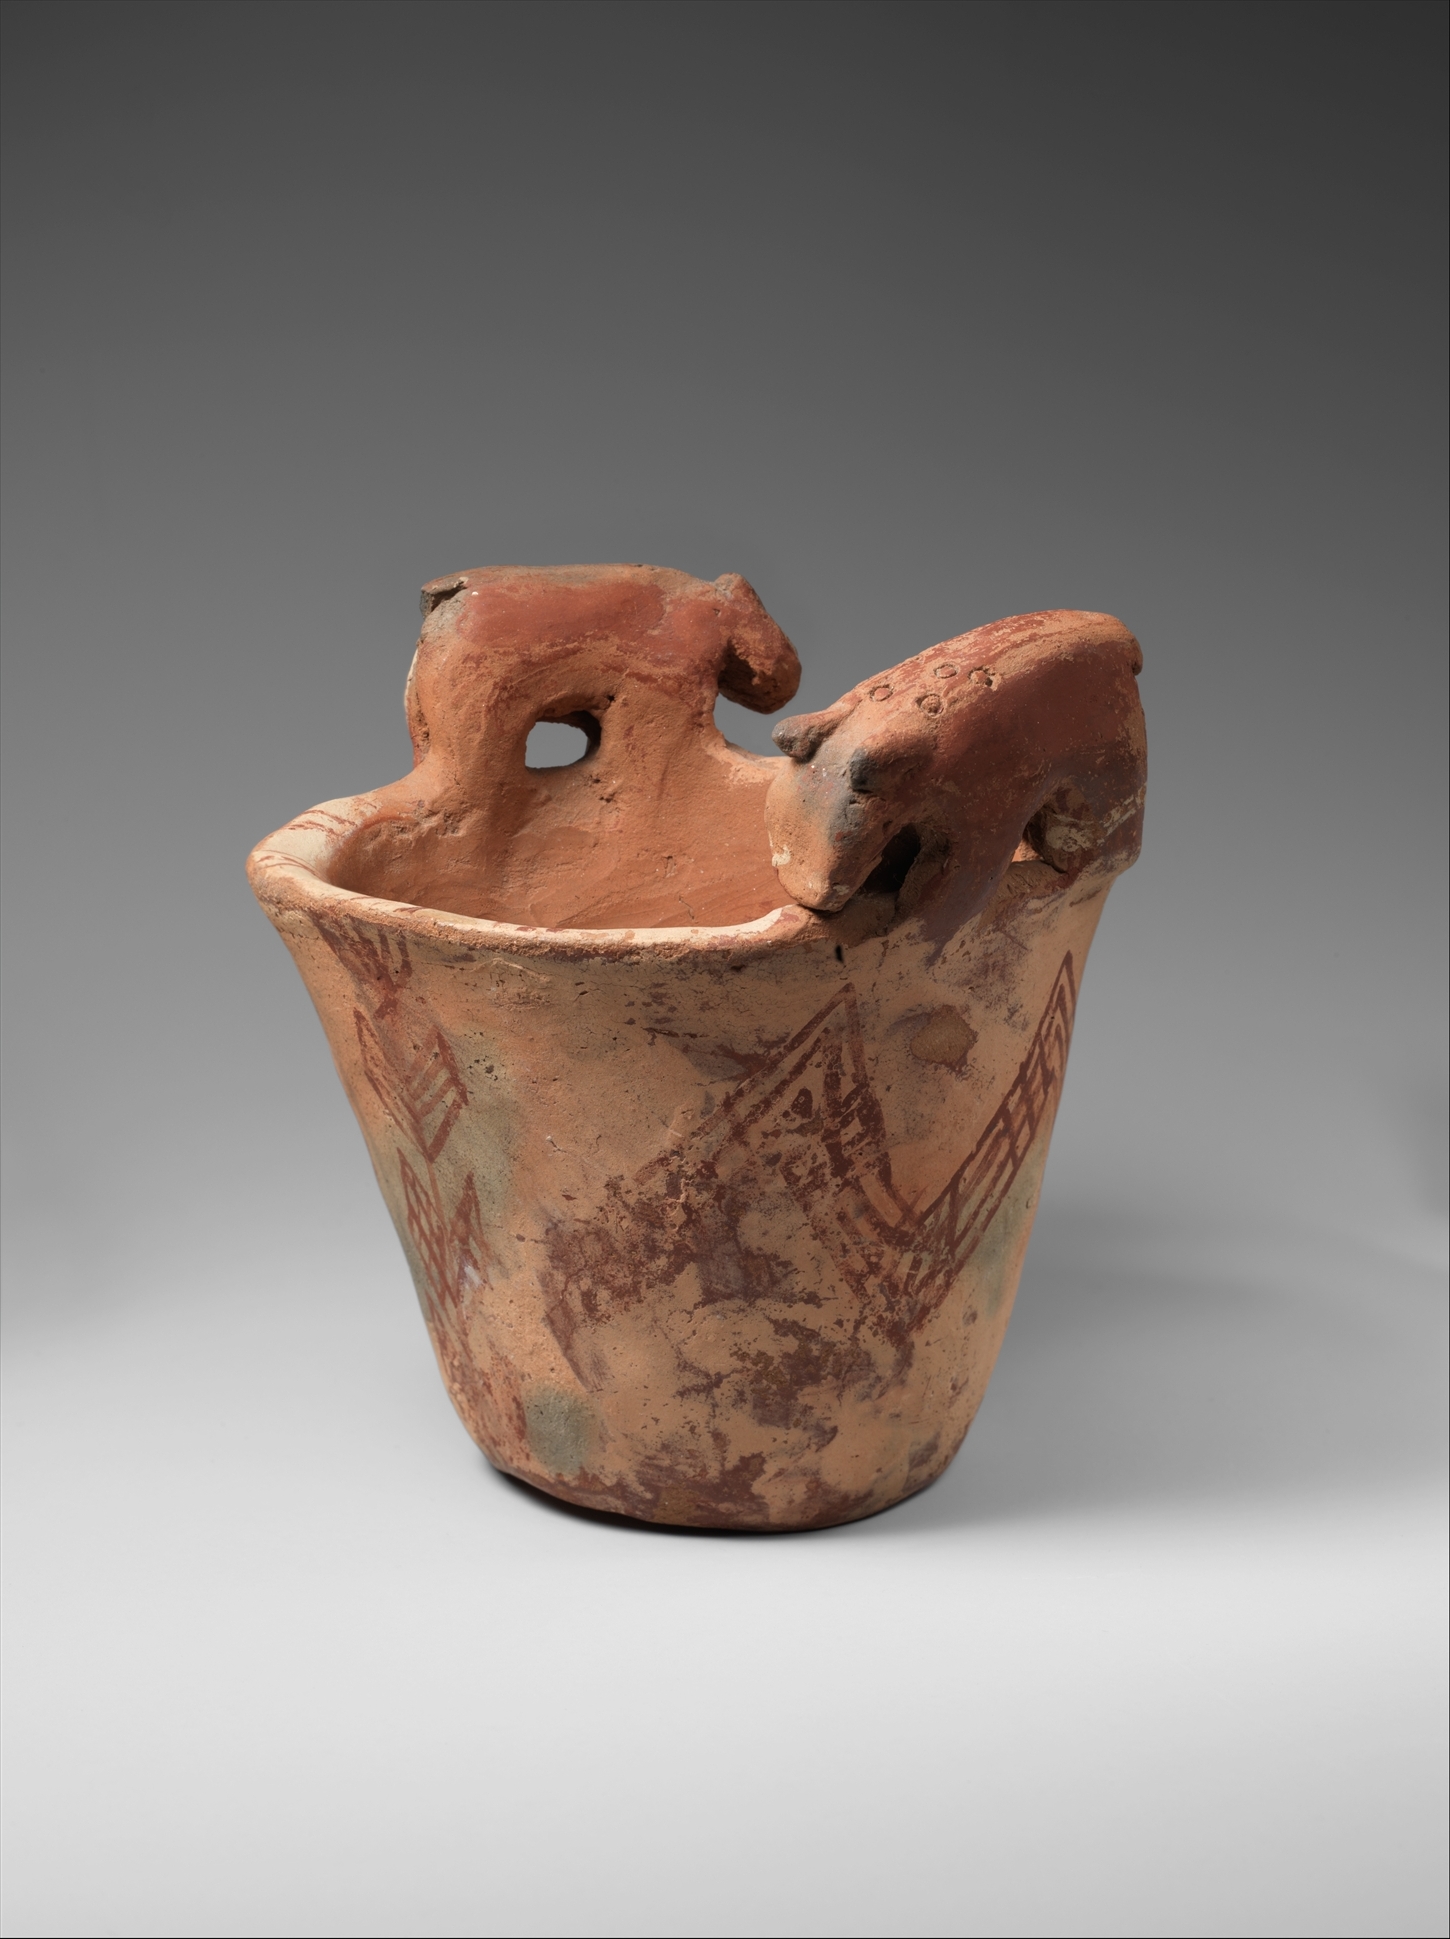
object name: beaker, hippo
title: White cross-lined ware beaker with hippos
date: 3650-3500 BCE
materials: paint, pottery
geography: egypt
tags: hippos